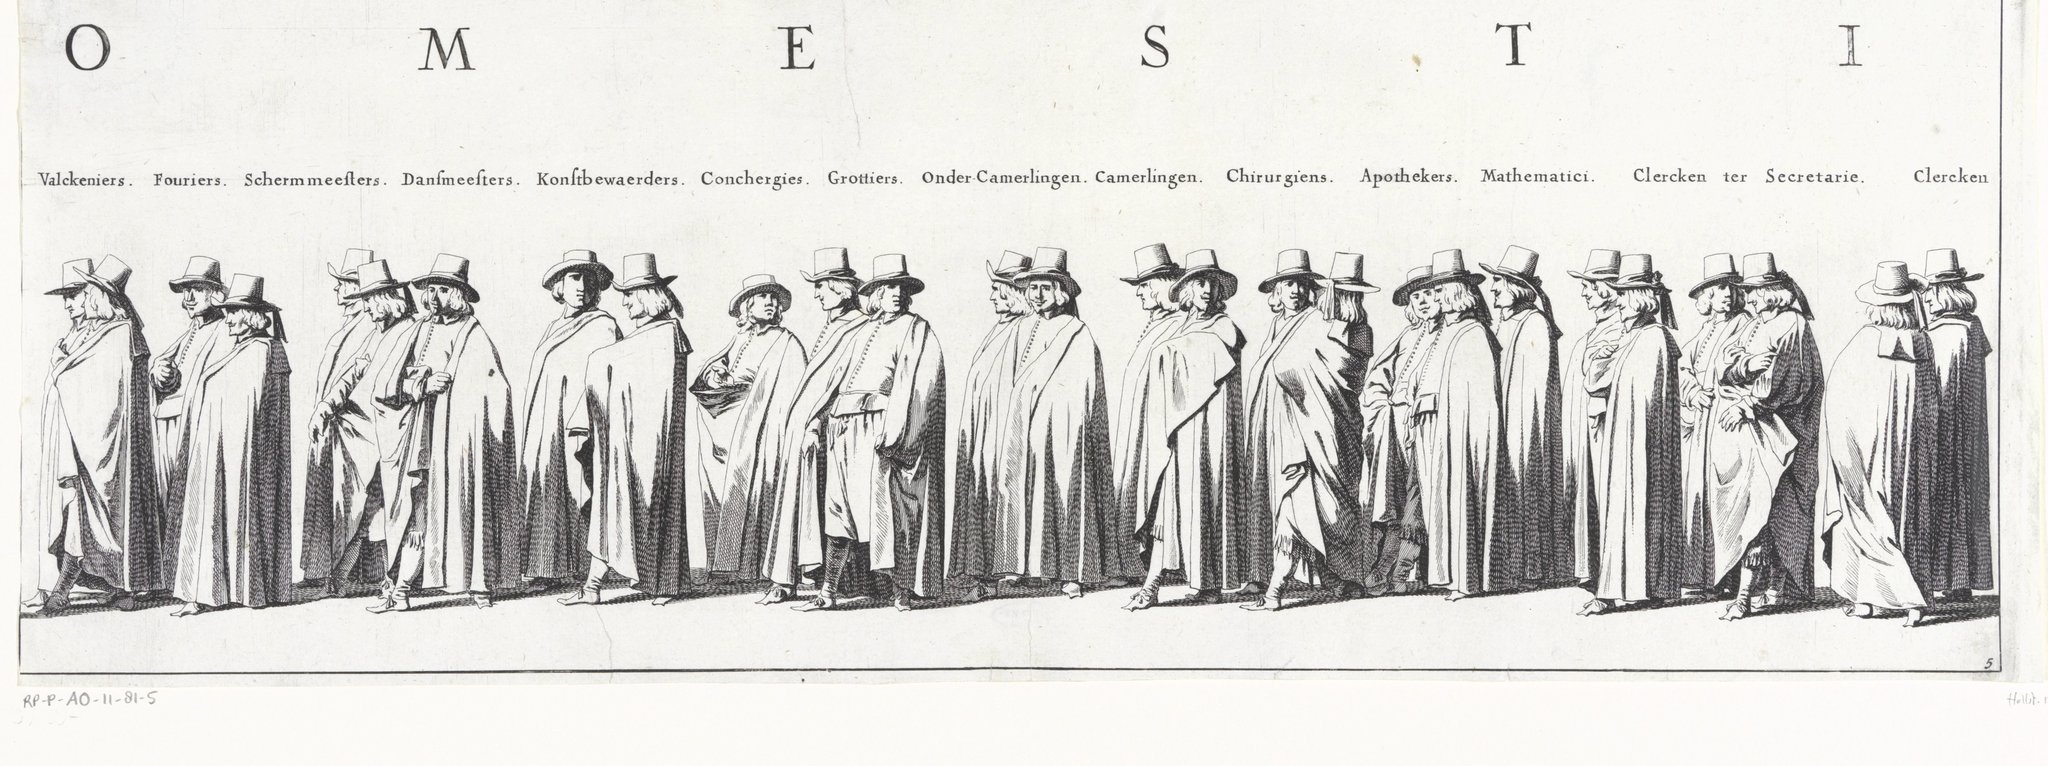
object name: print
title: De begrafenisstoet van Frederik Hendrik (plaat nr. 5), 1647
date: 1651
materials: paper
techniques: engraving, etching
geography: amsterdam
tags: cortege, funeral procession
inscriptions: collector's mark: Lugt 2228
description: De begrafenisstoet van stadhouder Frederik Hendrik te 's-Gravenhage op 10 mei 1647. Plaat nr. 5 met een deel van de stoet, boven de personen staat hun functie. Onderdeel van een serie van 30 platen en 20 tekstbladen, bedoeld om aan elkaar geplakt te worden.